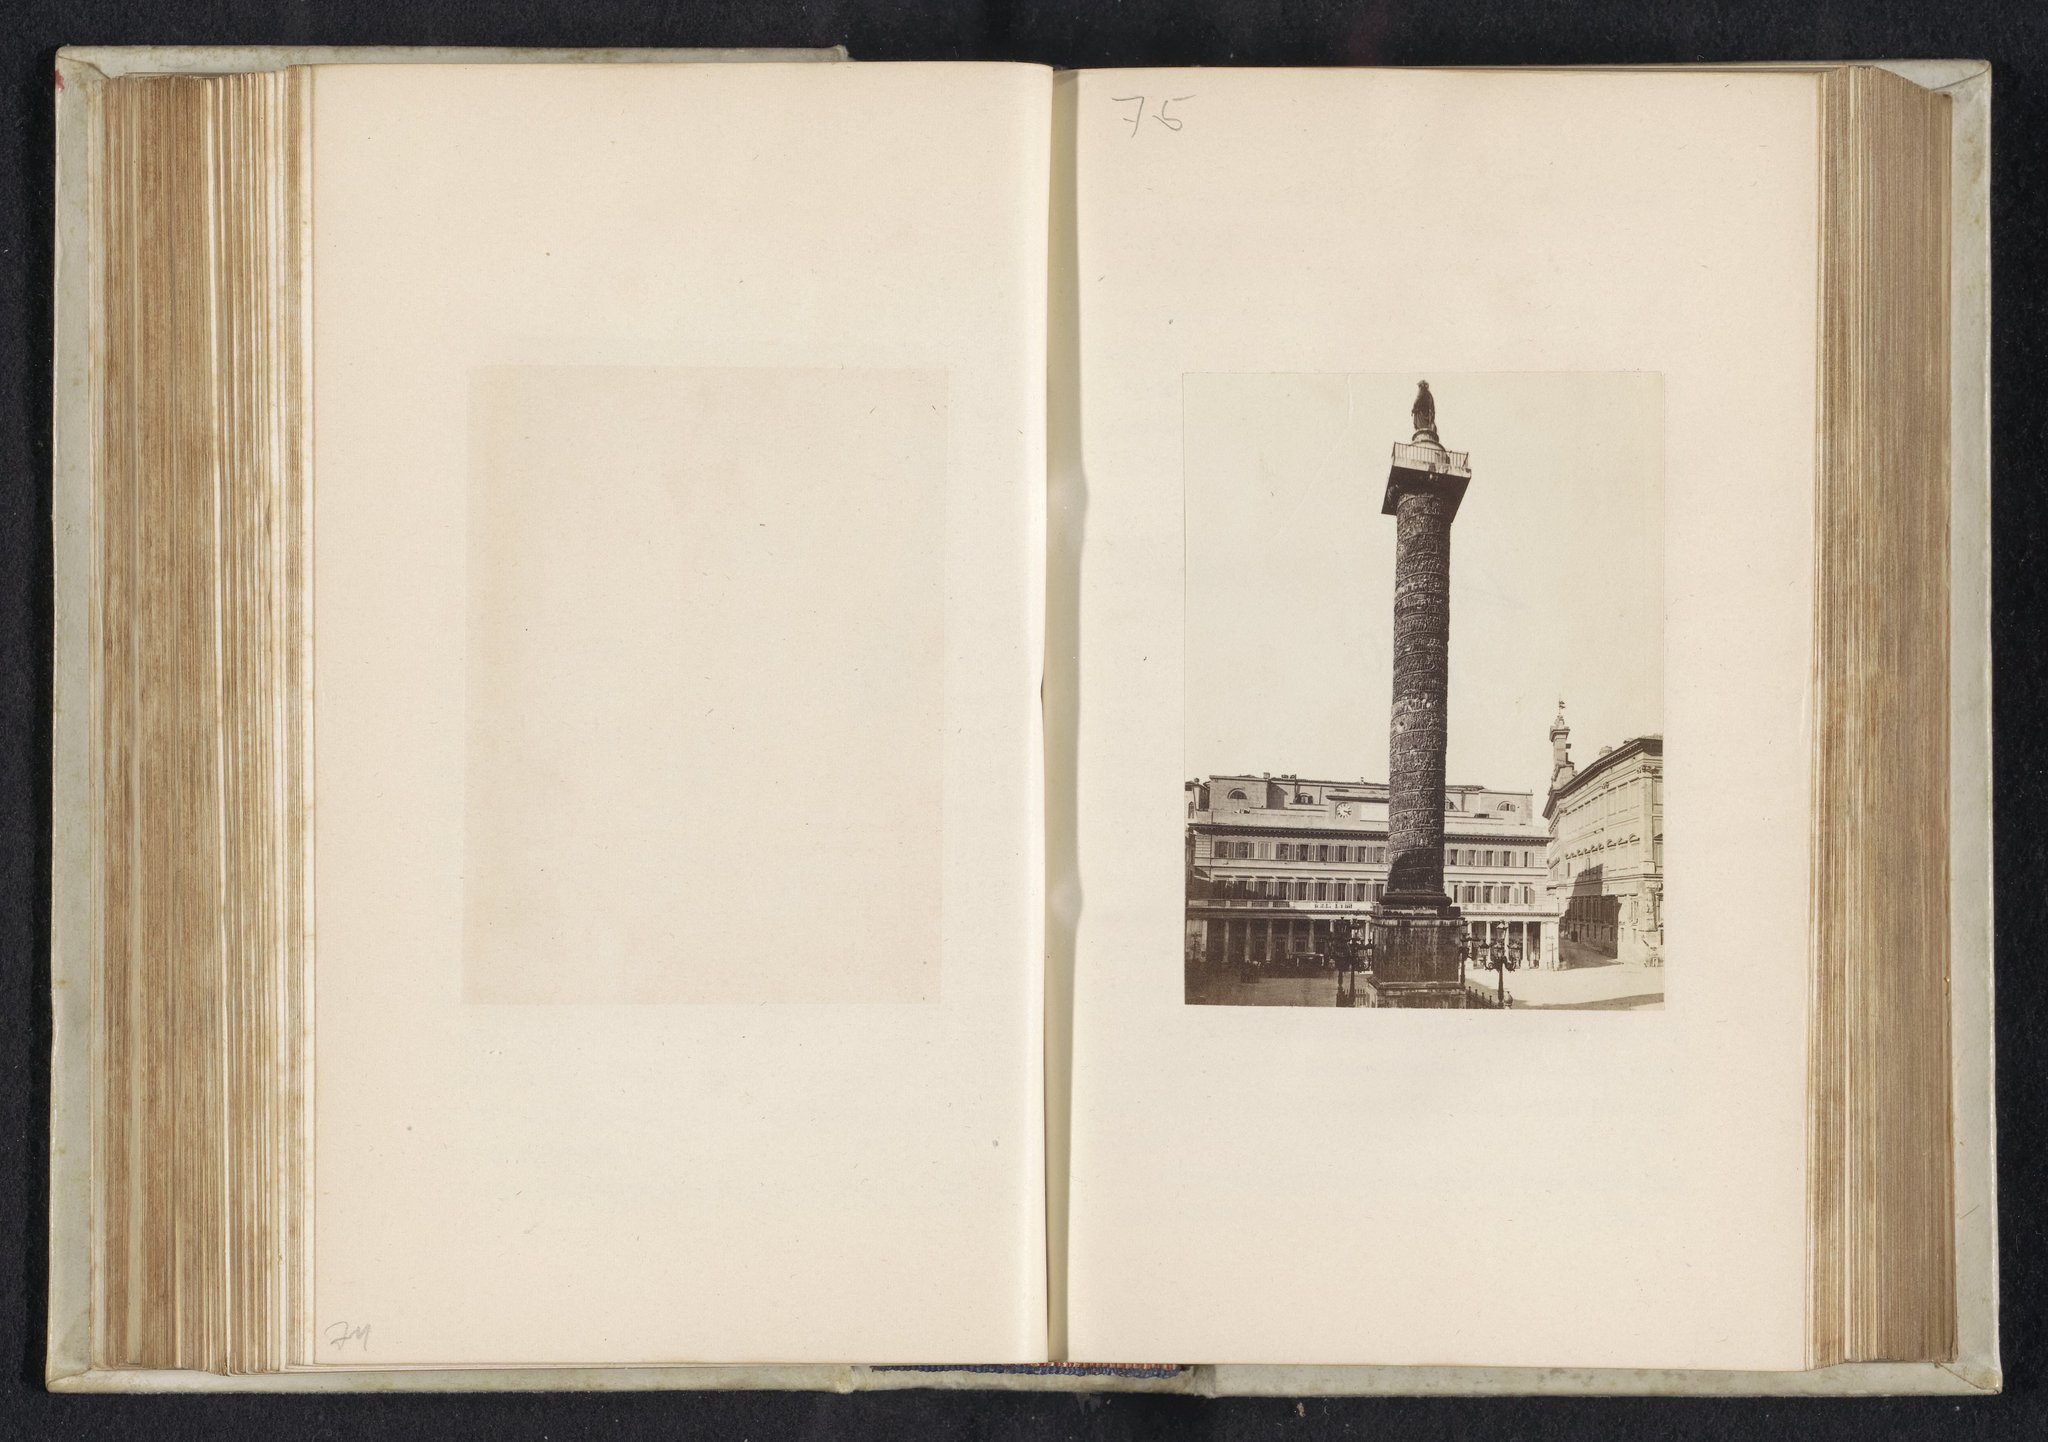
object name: photograph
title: Zuil van Marcus Aurelius op het Piazza Colonna te Rome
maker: Anonymous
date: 1850-1860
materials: photographic support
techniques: albumen print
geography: piazza colonna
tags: triumphal column with helical friezes, façade (of house or building)